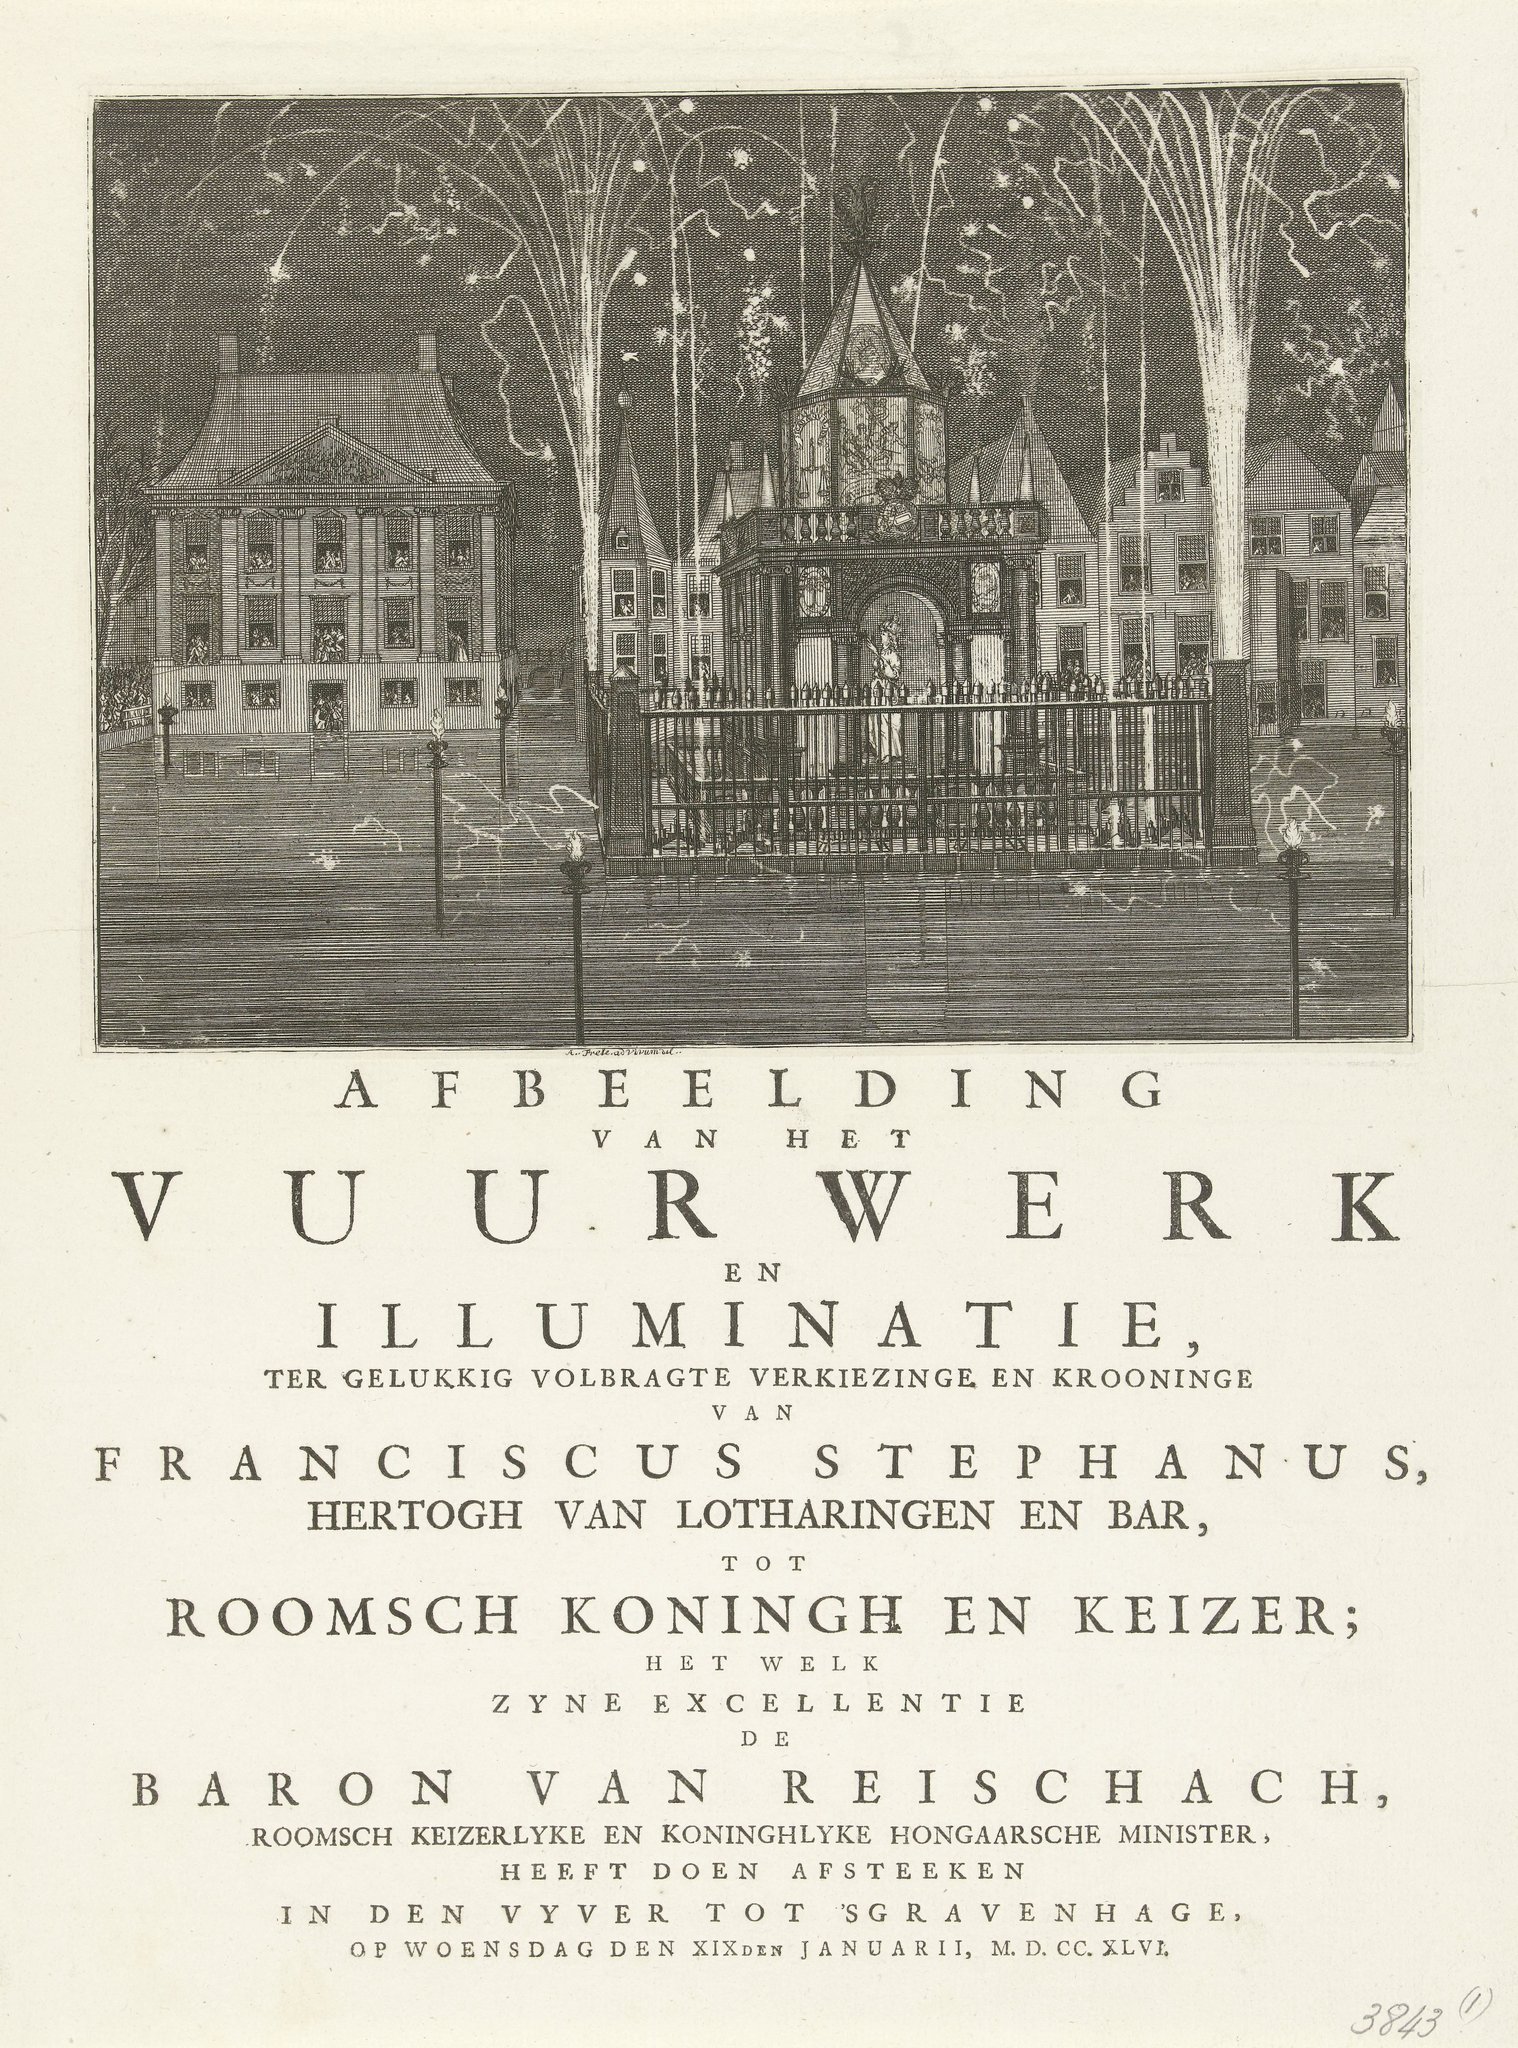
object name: print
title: Afbeelding van het vuurwerk en illuminatie, ter gelukkig volbragte verkiezinge en krooninge van Franciscus Stephanus, hertogh van Lotharingen en Bar, tot Roomsch koningh en keizer; het welk zyne excellentie de baron van Reischach, Roomsch keizerlyke en koninghlyke Hongaarsche minister, heeft doen afsteeken in den Vyver tot 's Gravenhage op woensdag den XIXden januarii, M.D.CC.XLVI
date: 1746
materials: paper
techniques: etching, letterpress printing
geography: northern netherlands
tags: frans i stefan (duits keizer), coronation of a ruler, bonfire, fire-works (+ illumination, fire-works ~ festive activities)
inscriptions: collector's mark: Lugt 2228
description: Vuurwerk afgestoken op 19 januari 1746 in de Hofvijver te Den Haag ter gelegenheid van de kroning van Frans I Stefan tot keizer op 4-6 oktober 1745. Het vuurwerk is afgestoken in opdracht van de baron van Reischach, minister in de Republiek namens de Duitse keizerskroon. Links op de achtergrond het Mauritshuis. De titel gedrukt op het blad onder de plaat.